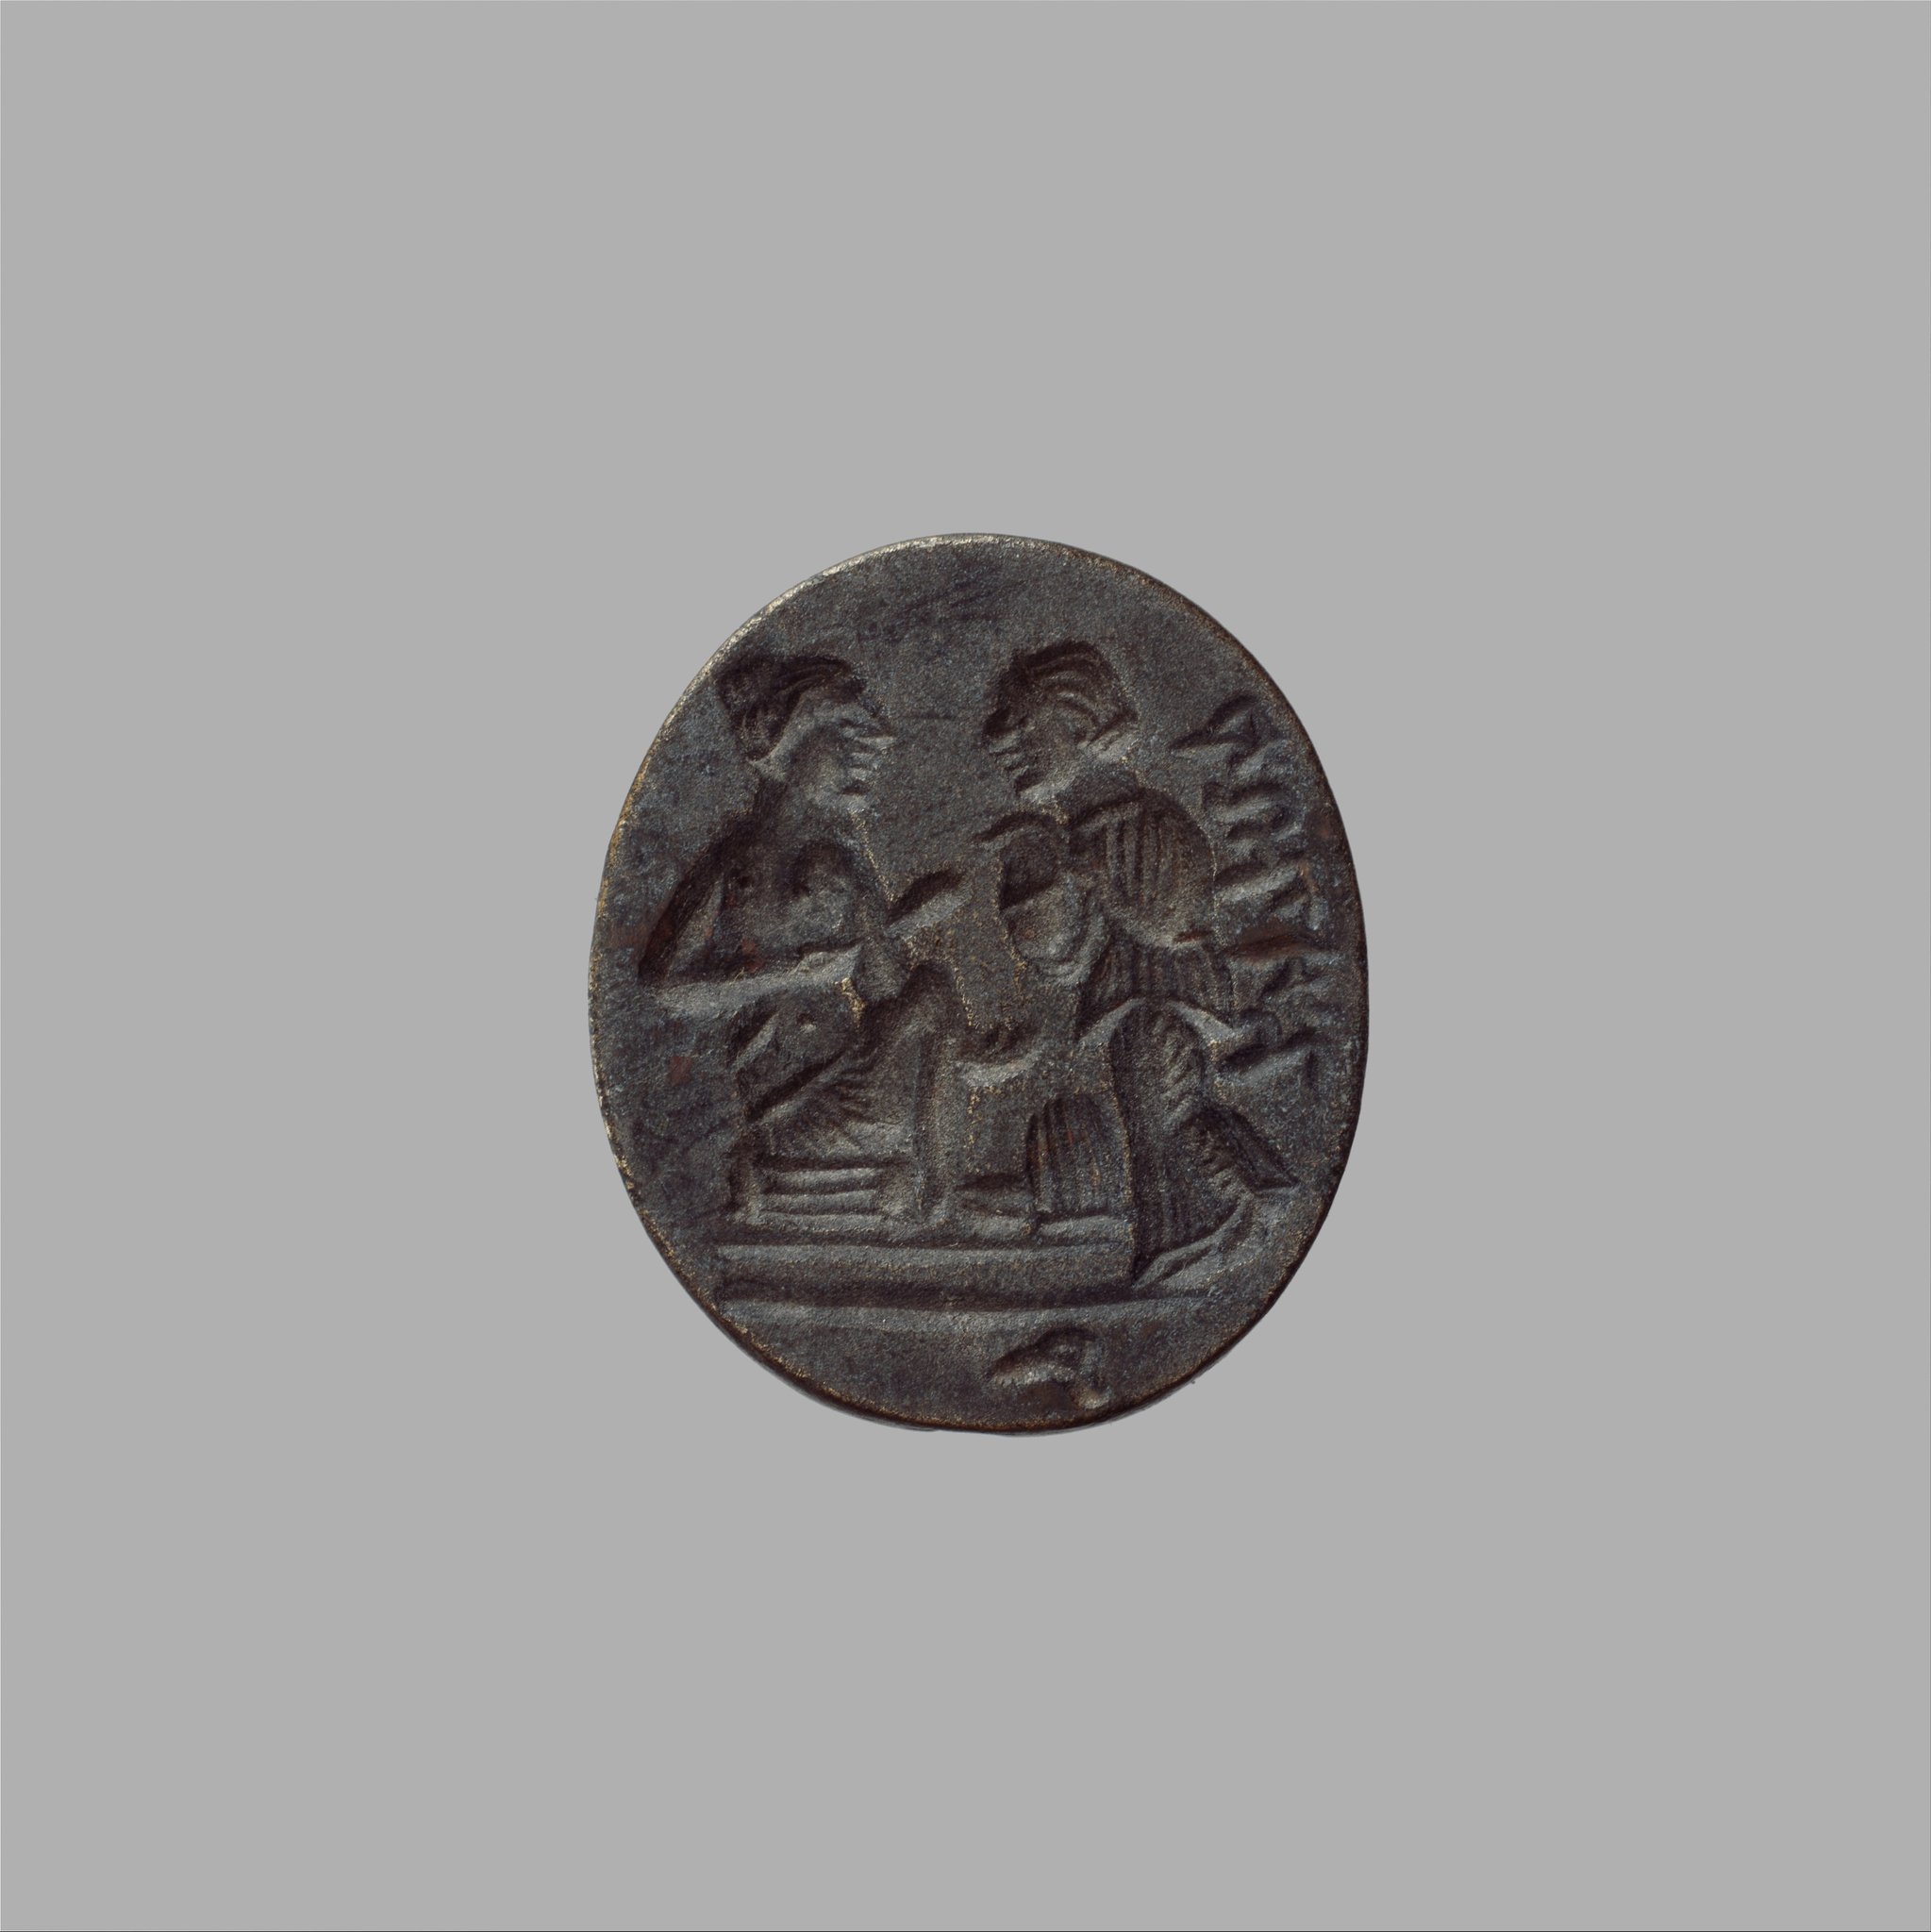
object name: intaglio in ring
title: Intaglio Ring with Two Figures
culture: gandhara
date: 100-1 BCE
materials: bronze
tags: gandhara,men,women